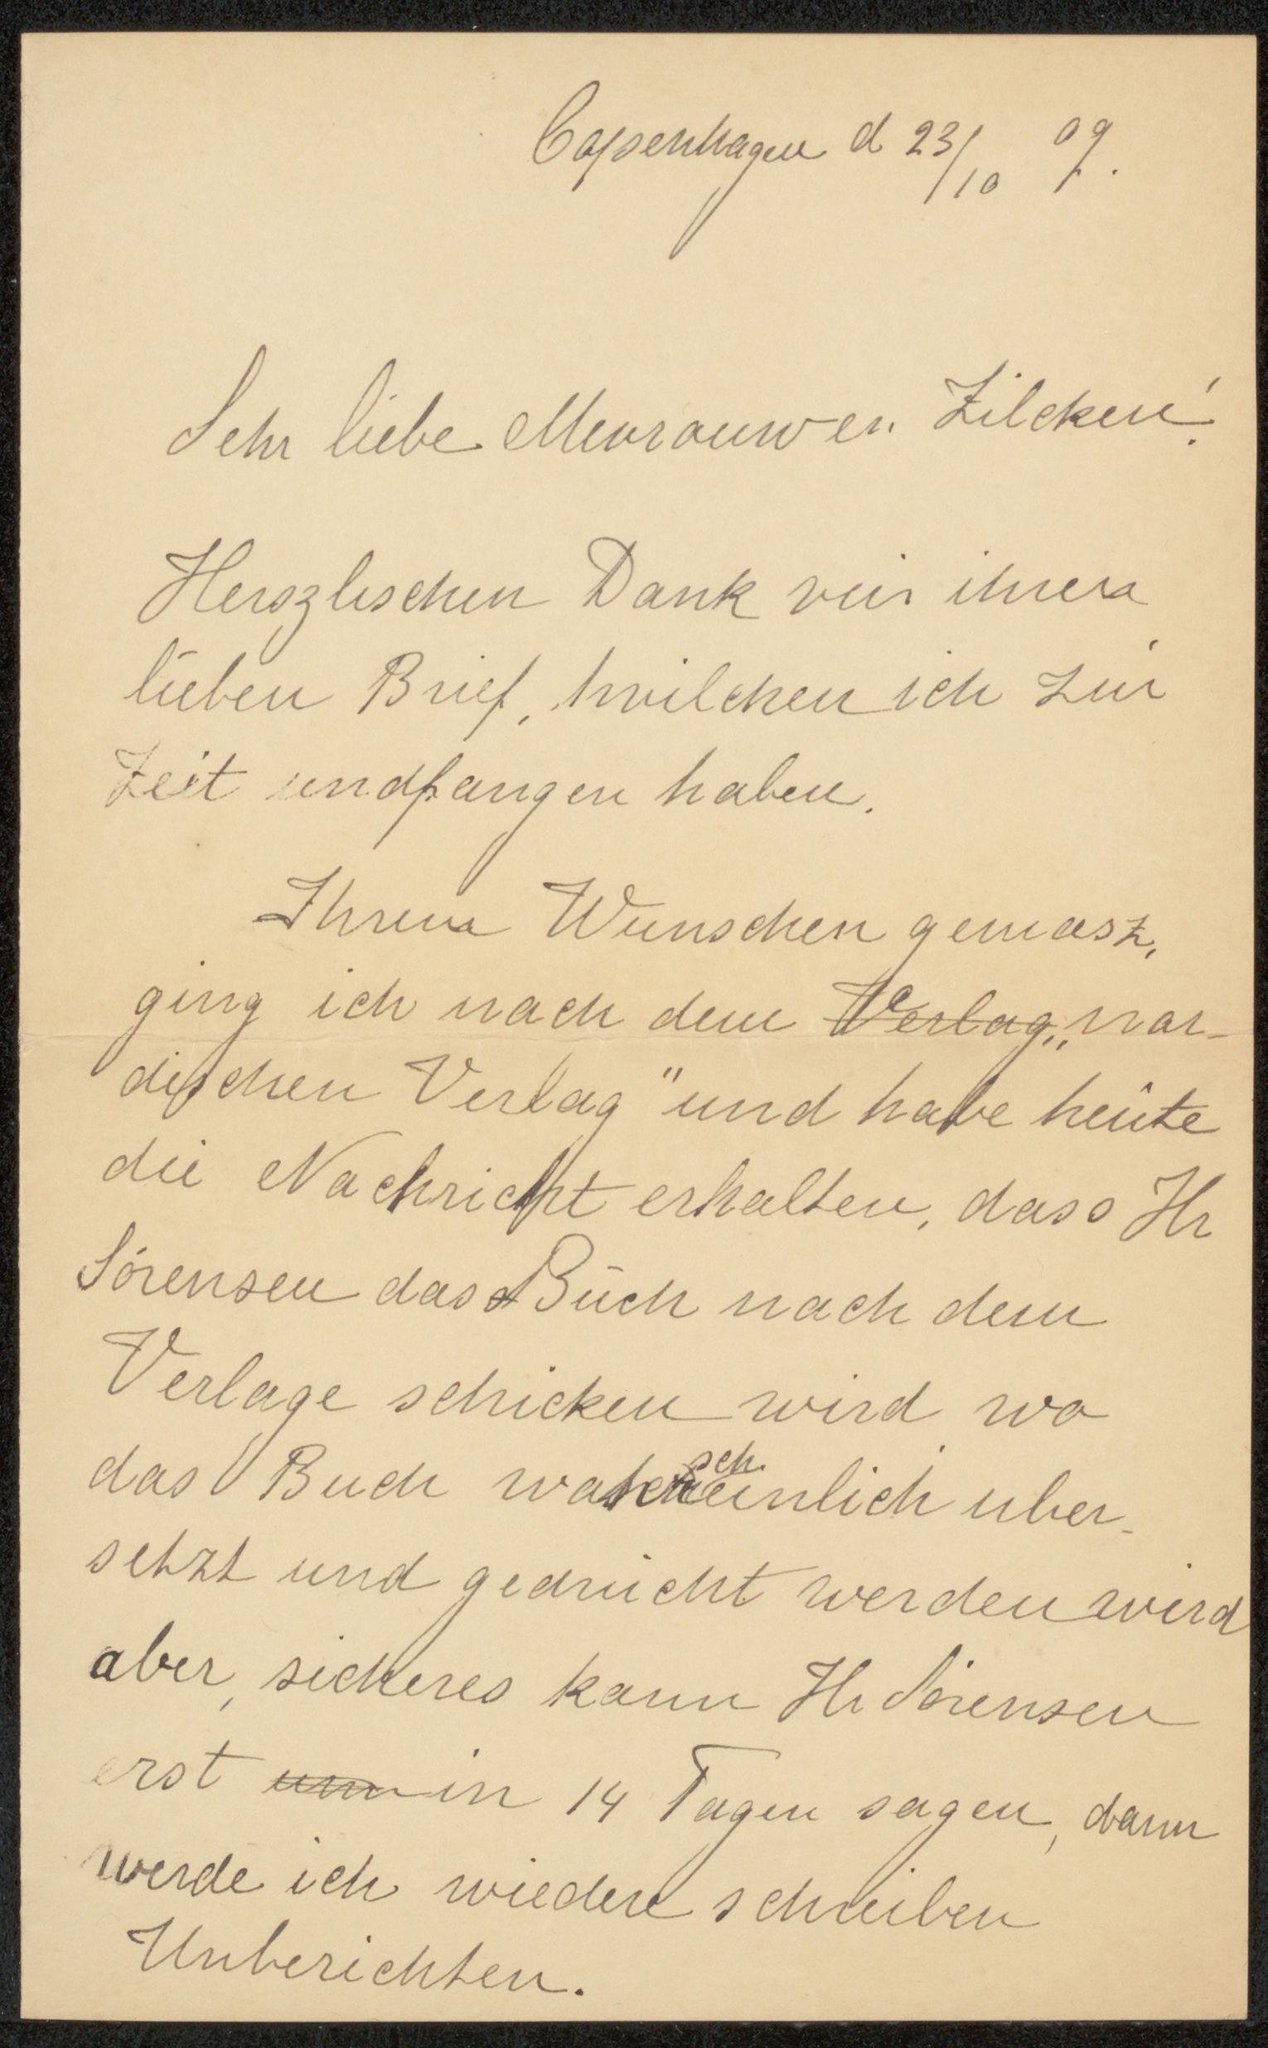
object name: letter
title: Brief aan Henriette Wilhelmina van Baak en Renée Hélène Laure Zilcken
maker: dagmar frandsen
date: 1909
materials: ink, paper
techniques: pen, writing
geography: copenhagen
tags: voorburg, renée hélène laure zilcken, henriette wilhelmina van baak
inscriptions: collector's mark: ‘RPK’